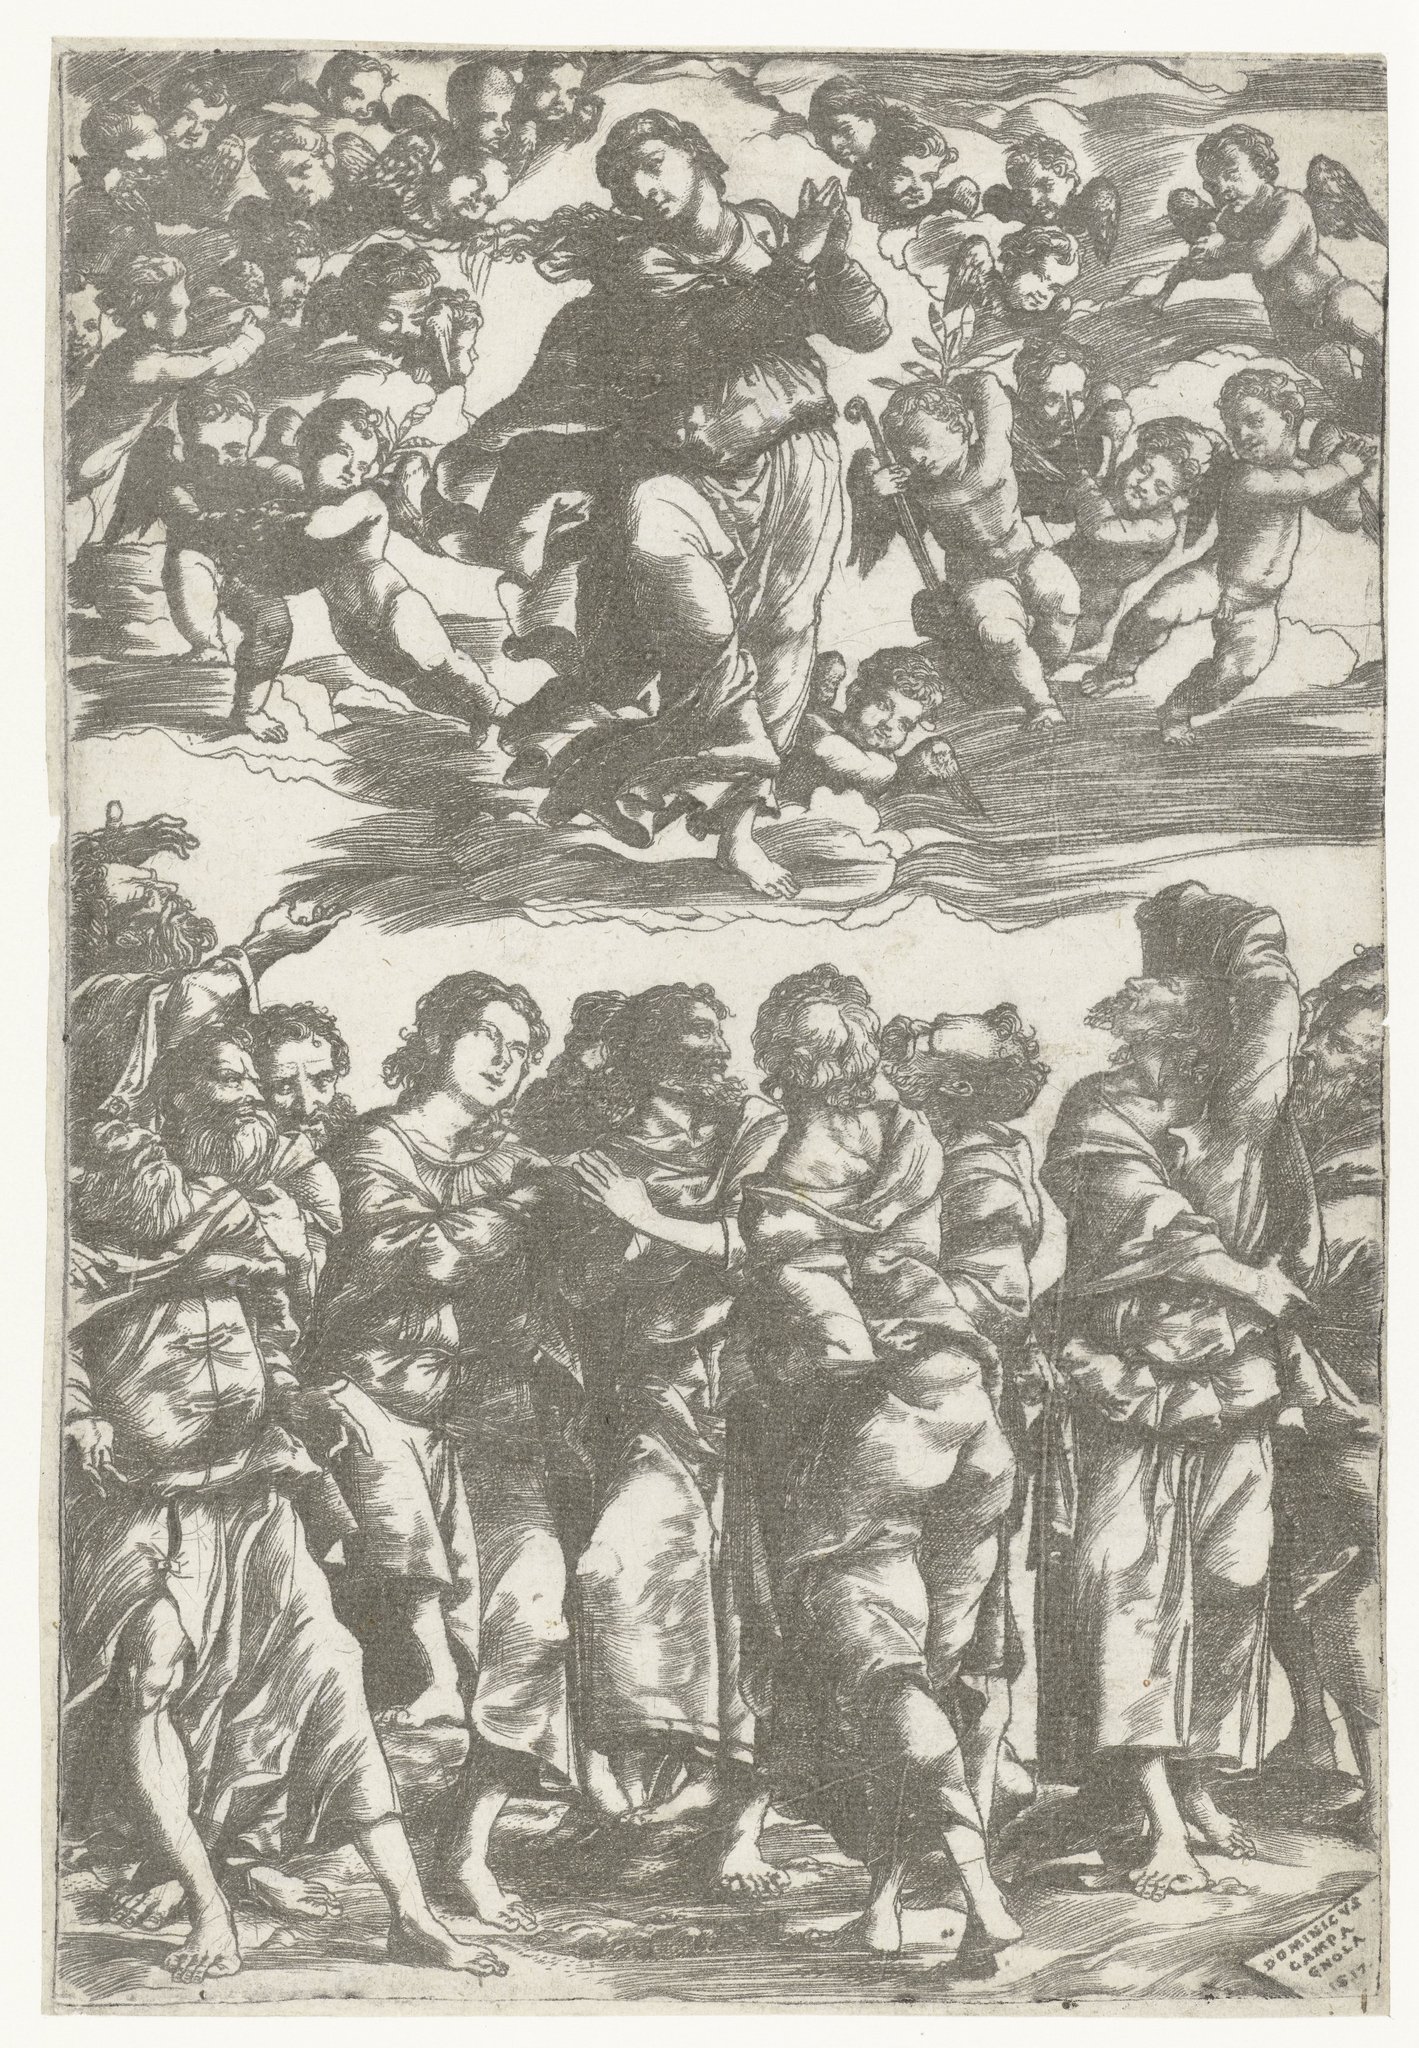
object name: print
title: Hemelvaart van Maria met apostelen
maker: domenico campagnola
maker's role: draughtsman, painter, print maker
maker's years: 1500-1564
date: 1517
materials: paper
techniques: engraving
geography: italy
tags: the assumption of mary ('assumptio corporis'): she is borne into heaven by angels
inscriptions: collector's mark: Lugt 11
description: De kunstenaar liet zich duidelijk inspireren door werk van Titiaan maar geen detail is letterlijk overgenomen (zie documentatie).